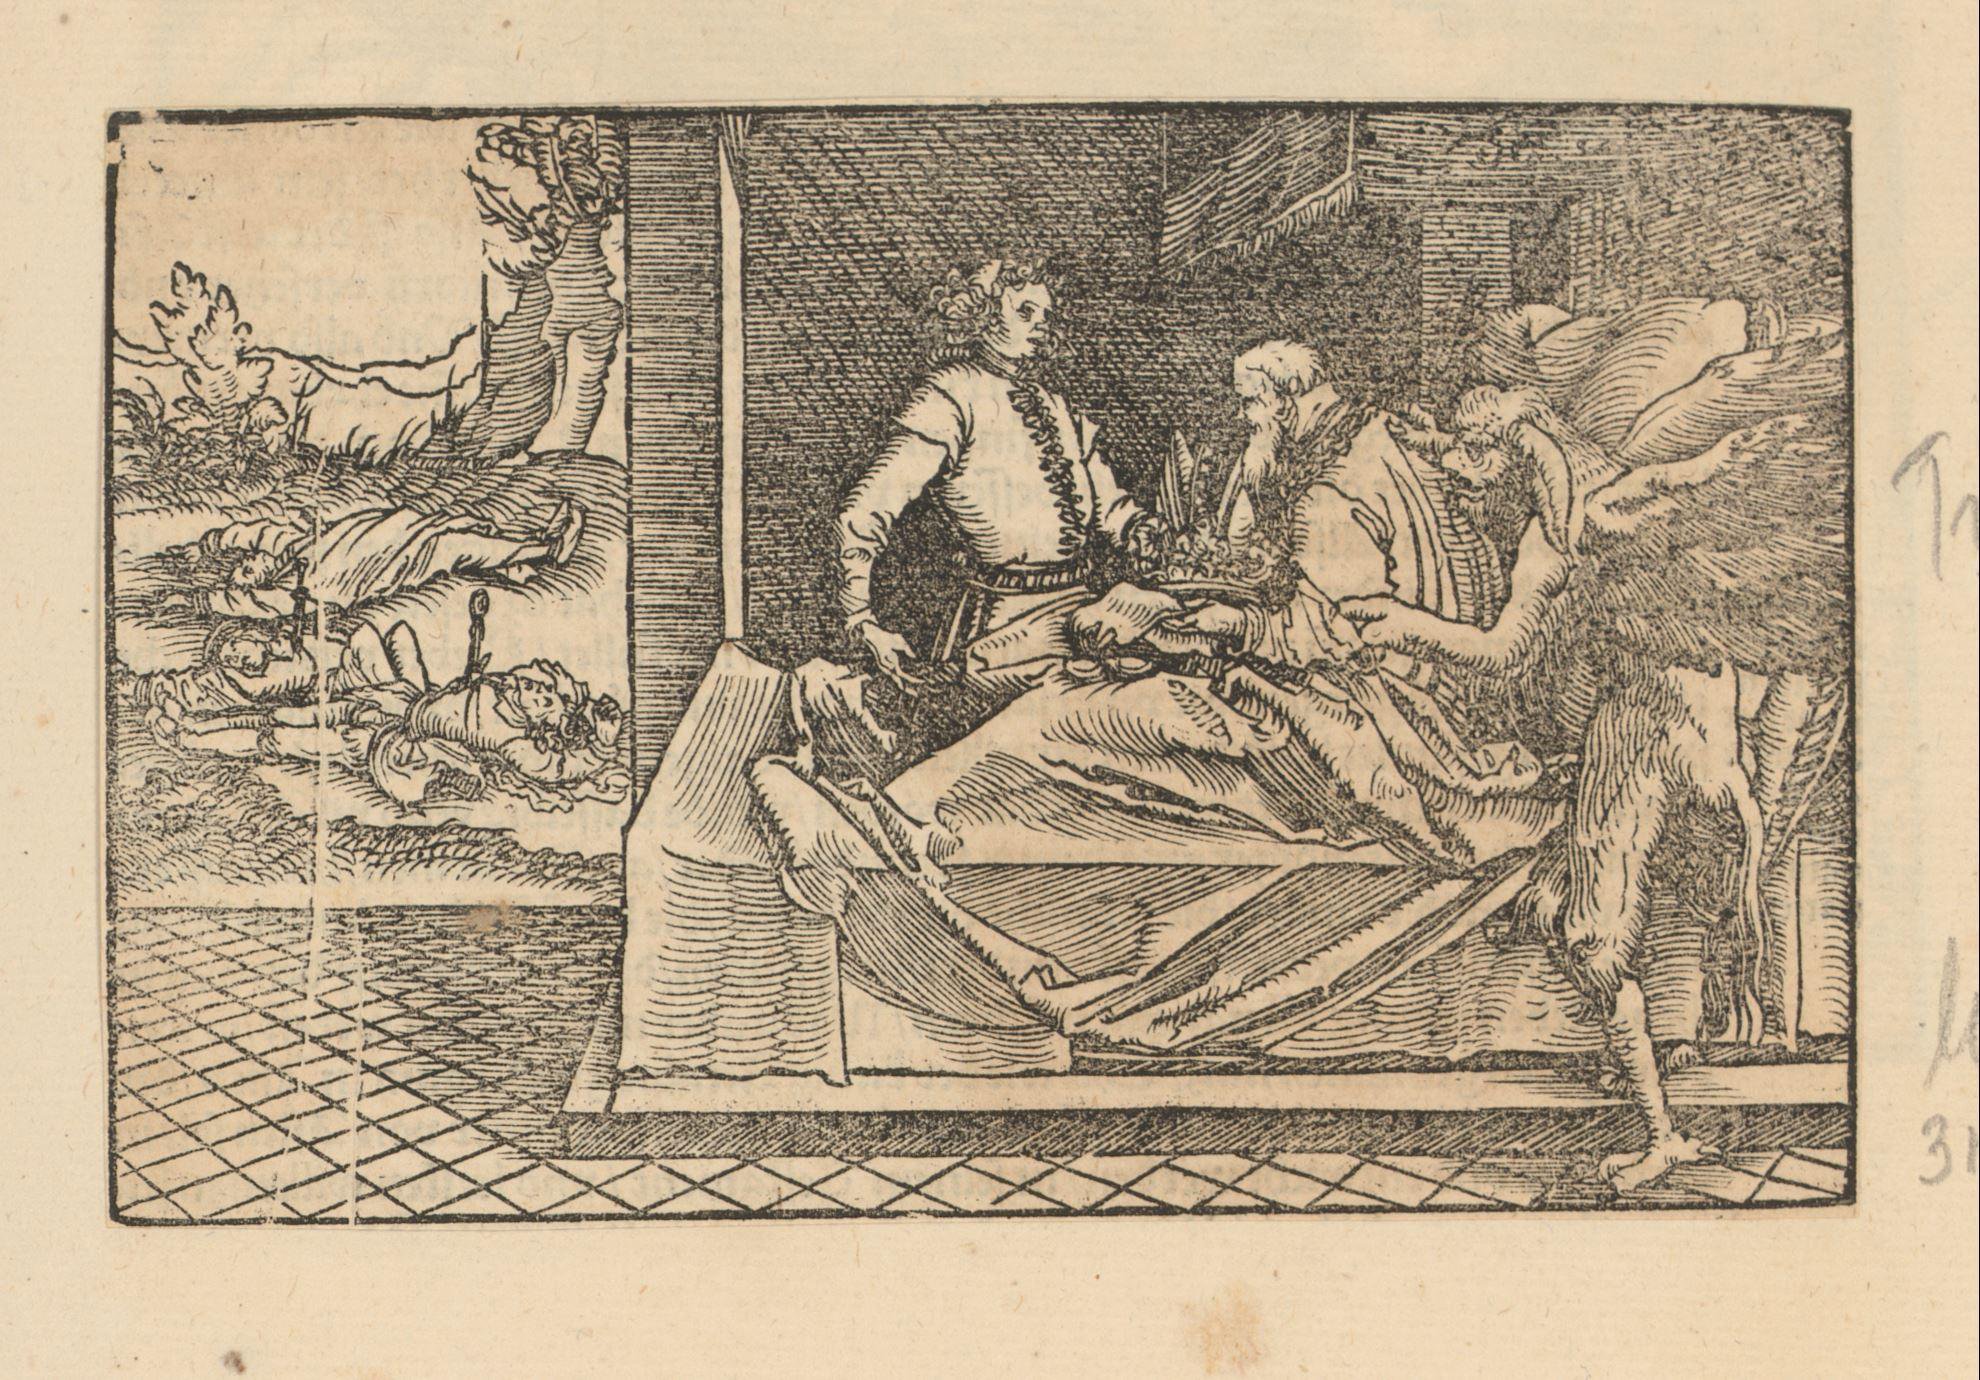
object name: print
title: Man op zijn sterfbed, vastgehouden door een duivel, staat zijn kroon af aan een ander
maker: Anonymous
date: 1514-1532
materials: paper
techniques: letterpress printing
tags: death as devilish being, death struggle, inquiet death; fear of death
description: Deze prent is gebruikt in: Petrarca, Francesco. Von der Artzney bayder Glück, des guten und widerwertigen: unnd weß sich ain yeder inn Gelück und Unglück halten sol (...). Augsburg: Heinrich Steiner, 1532. Deze uitgave is ook bekend onder de titel 'Trostspiegel in Glück und Unglück'.